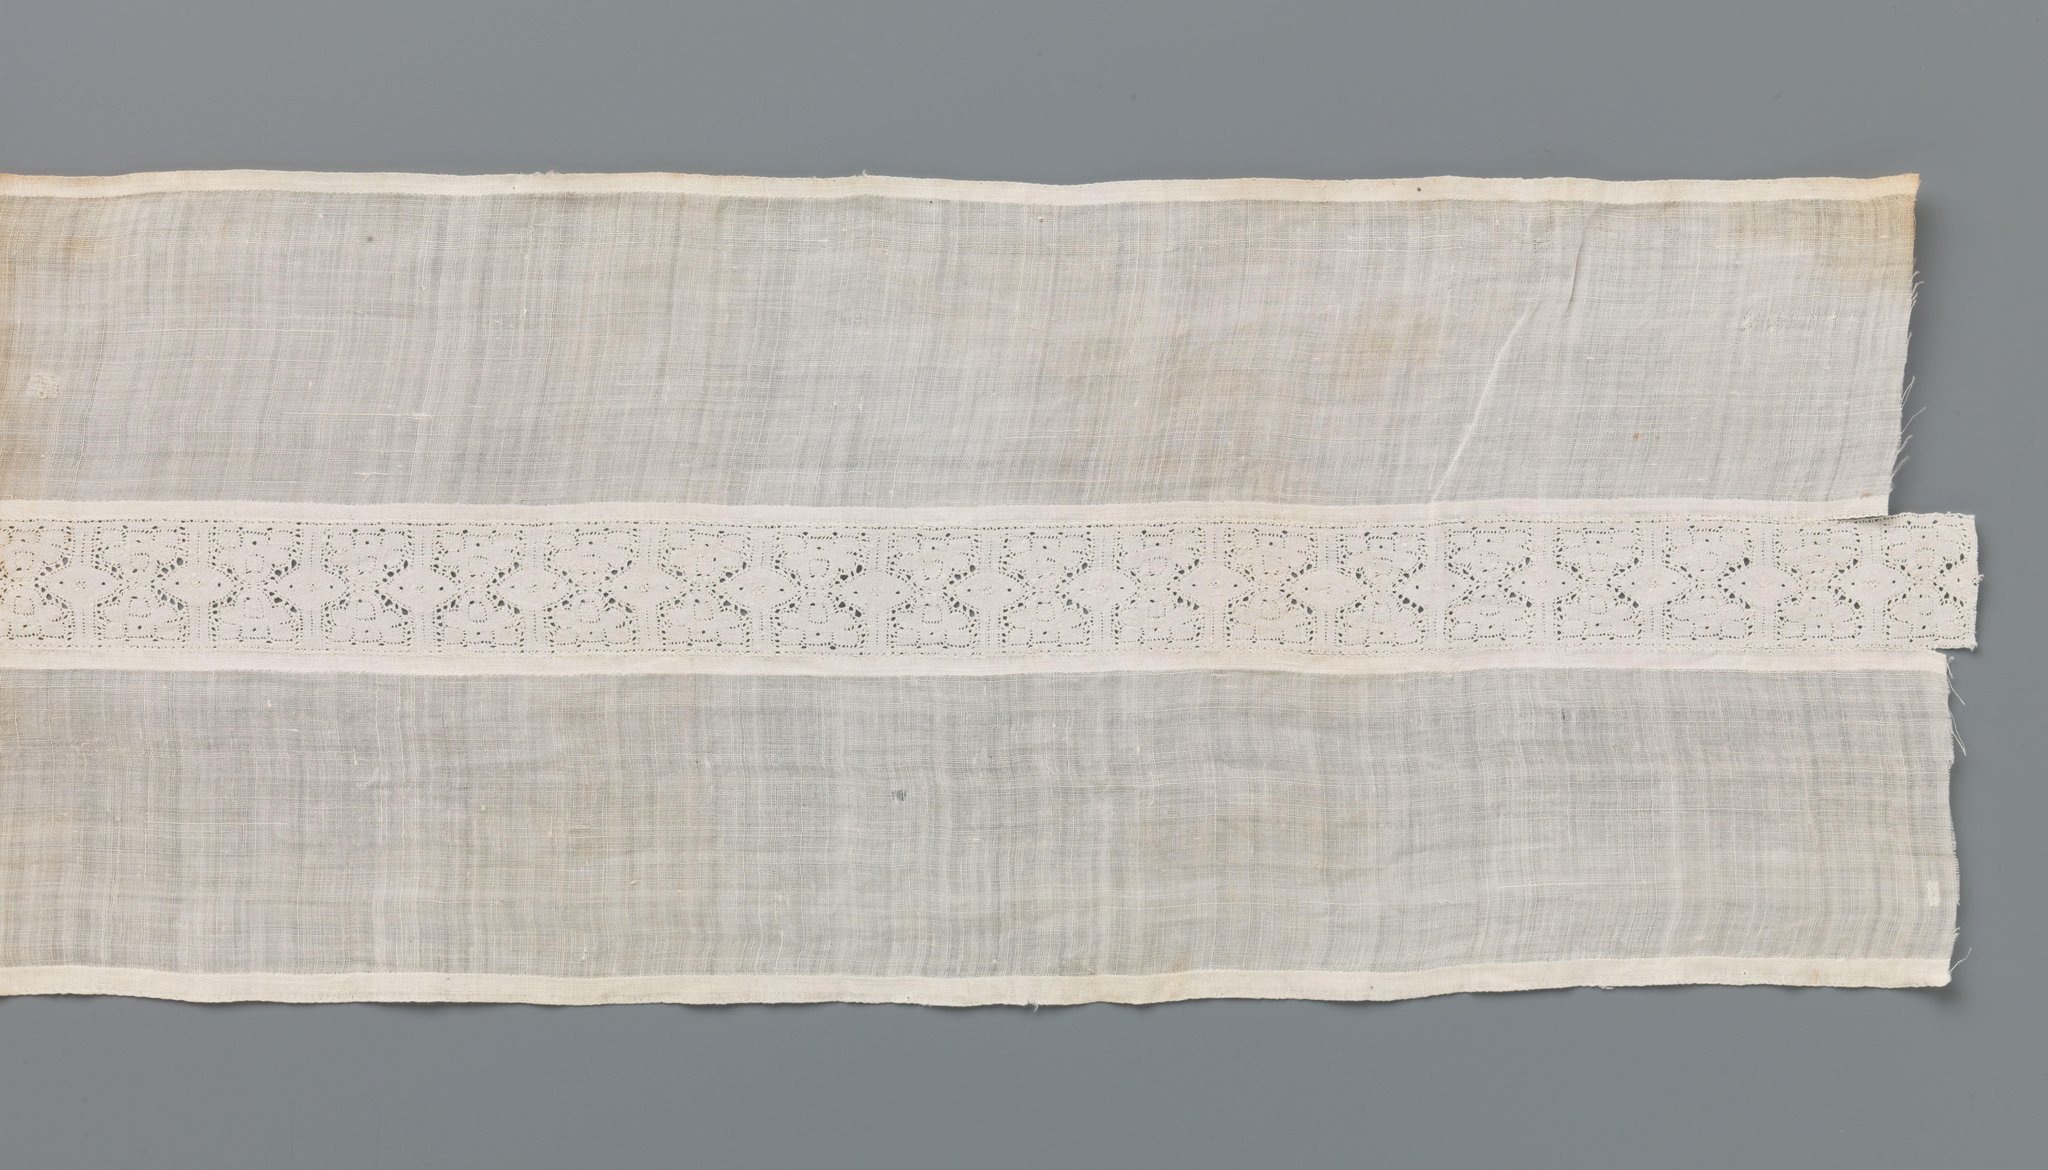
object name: entre deux, tussenzetsel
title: Strook linnen batist met een tussenzetsel van kloskant met twee gestileerde gespiegelde bloemen tussen vertikale lijnen en ovalen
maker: Anonymous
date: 1600-1635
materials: linen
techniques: lace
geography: southern netherlands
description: Strook linnen batist met een tussenzetsel van naturelkleurige Hollandse kloskant. Het kant heeft een zich herhalend motief dat bestaat uit vertikale rechte lijnen, die in het midden worden oversneden door een spitsovaal. Tussen de vertikale lijnen staan twee gestileerde bloemen, die over de lengte-as zijn gespiegeld. De motieven zijn gemaakt in dicht opeengewerkte linnenslag met uitsparingen. Er is nauwelijks sprake van een grond, de motieven worden door zeer korte vlechtjes bij elkaar gehouden.